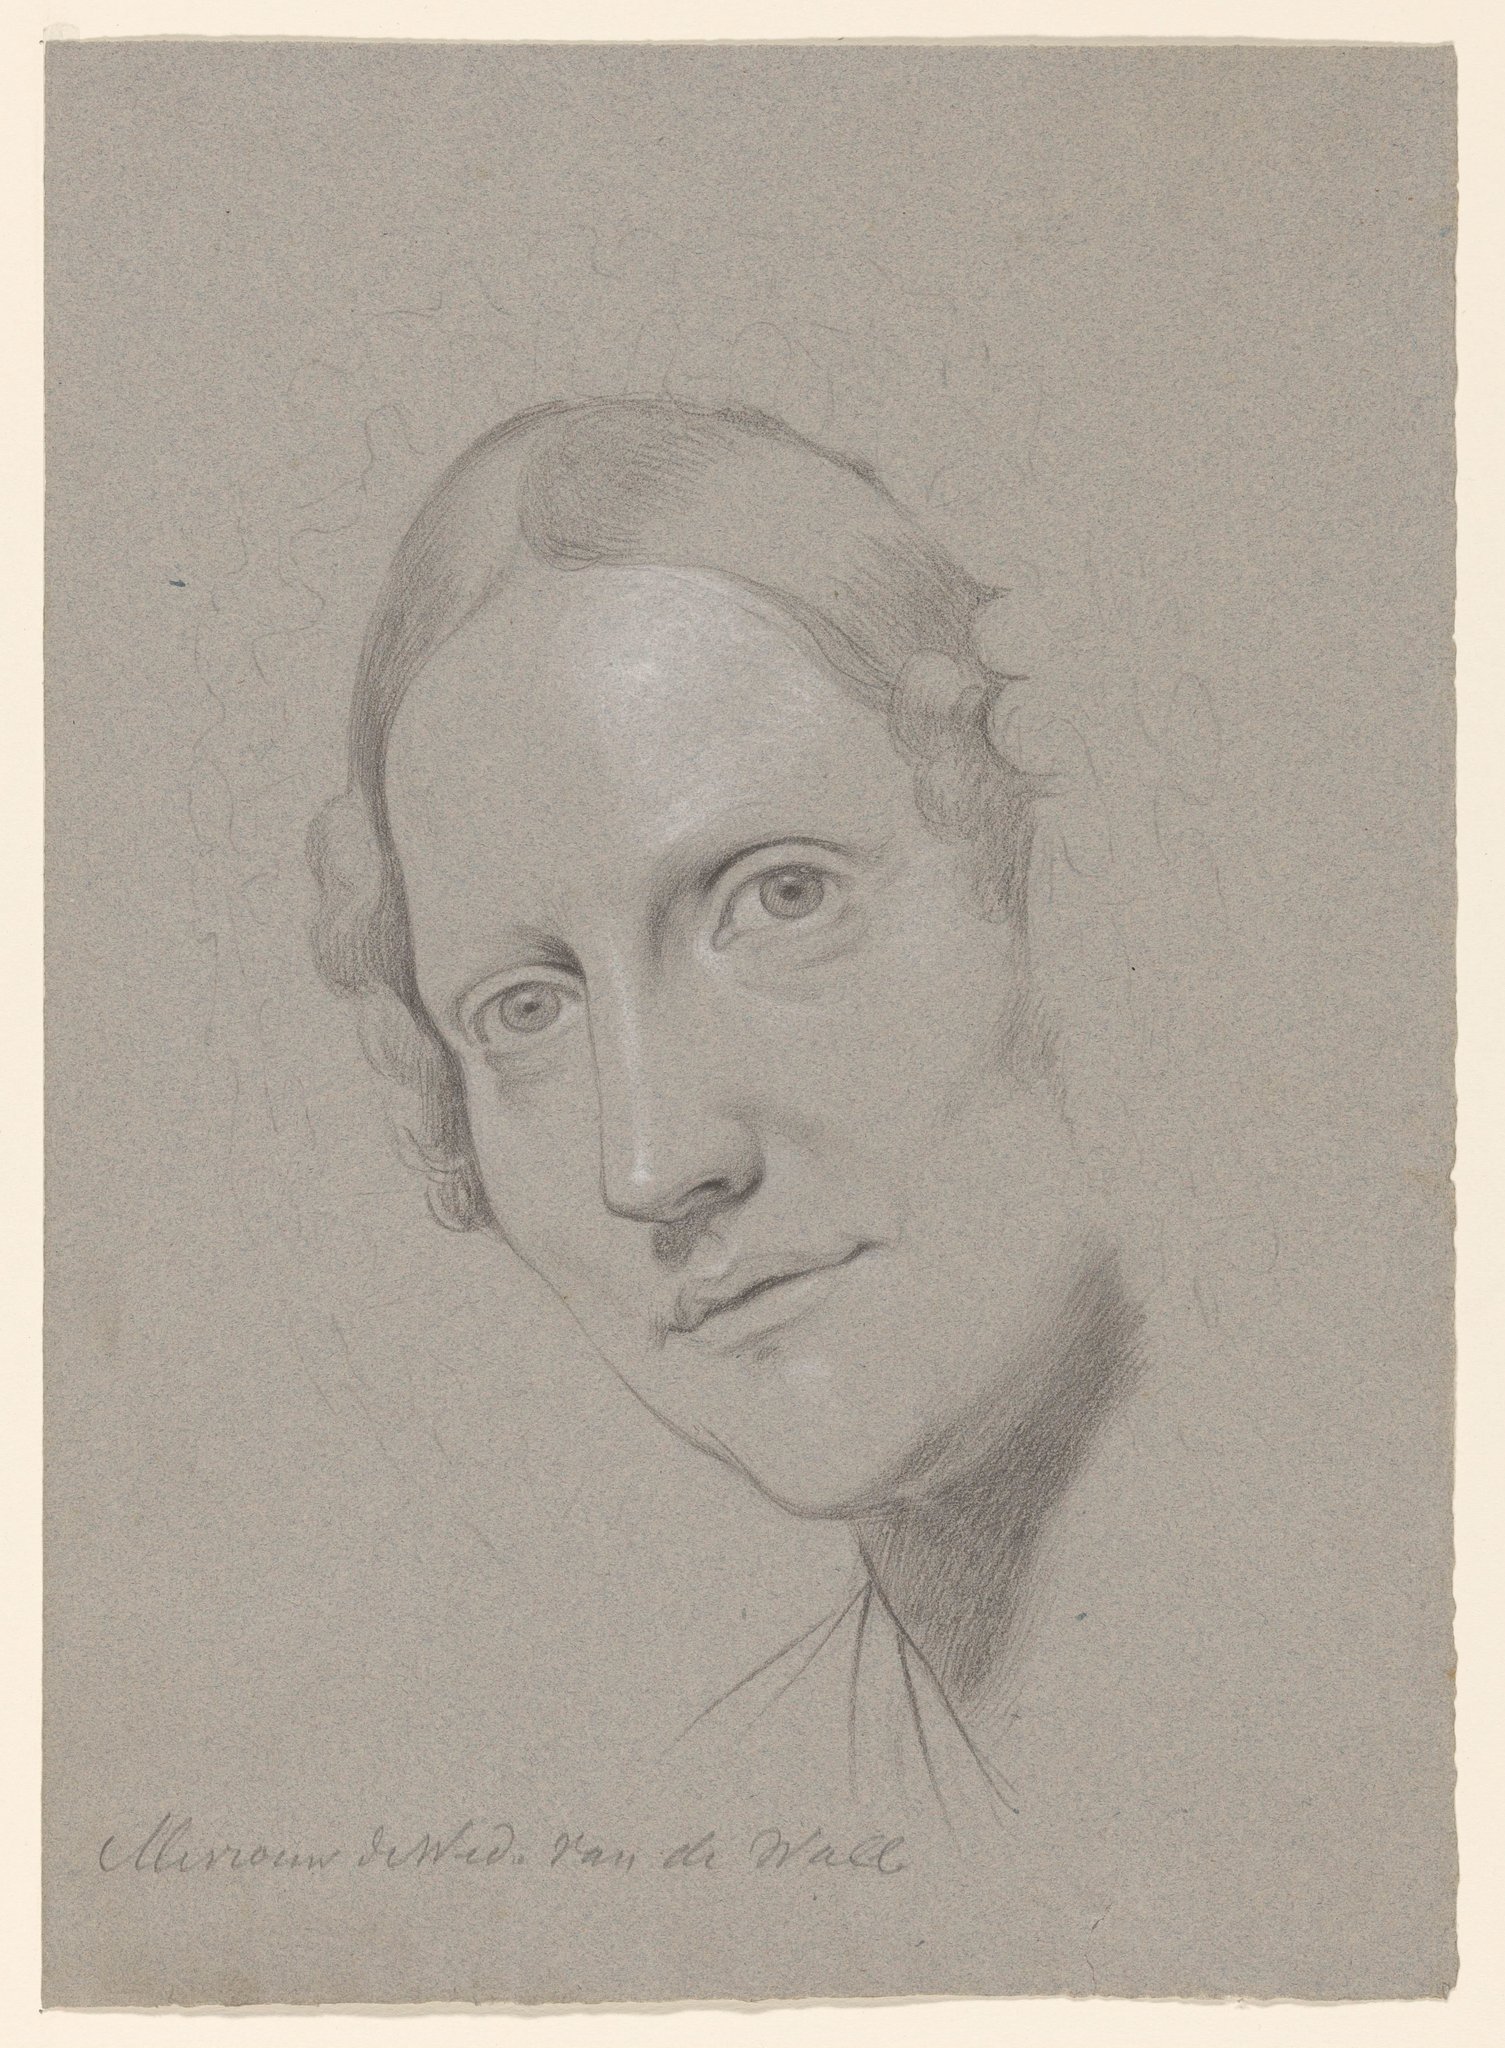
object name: drawing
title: Portret van Mevrouw de Wed. van de Wall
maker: jan adam kruseman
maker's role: draughtsman, painter, print maker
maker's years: 1804-1862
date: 1814-1862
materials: chalk, paper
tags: historical persons